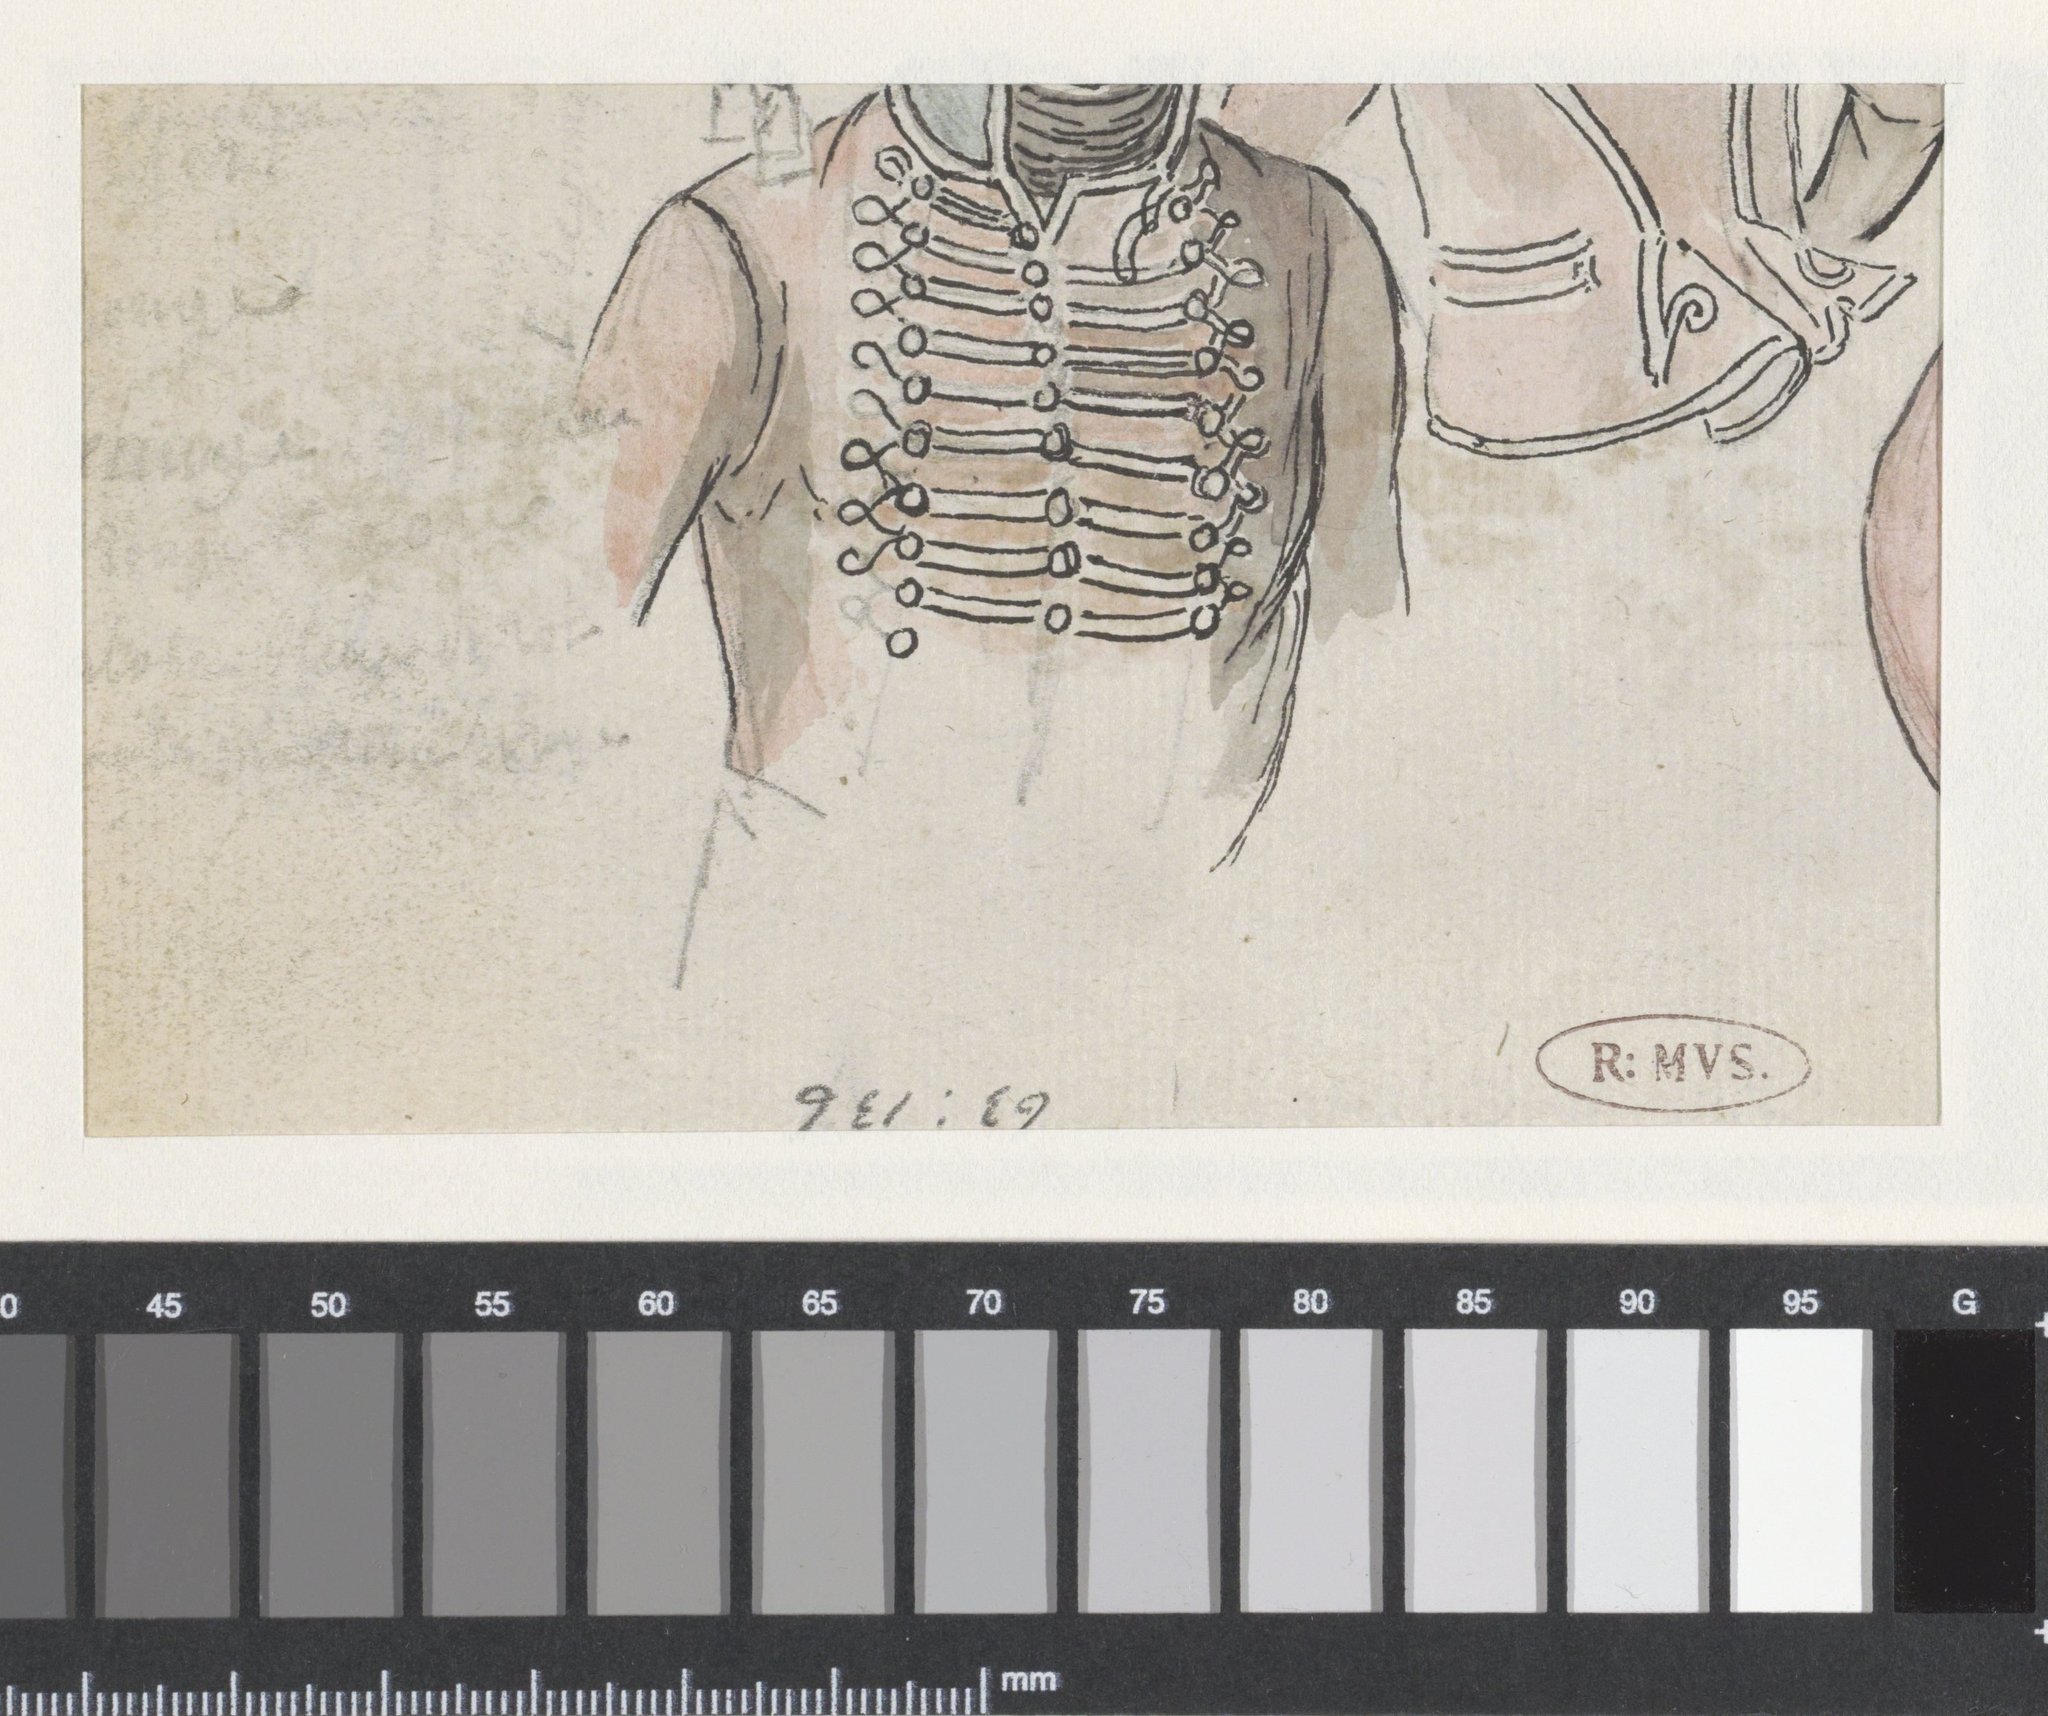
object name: drawing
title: Schetsen van huzaren (afgesneden)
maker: georges michel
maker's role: draughtsman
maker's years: 1763-1843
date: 1773-1843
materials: ink, paper, pencil, watercolor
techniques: brush, pen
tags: (military) uniforms (+ cavalry, horsemen)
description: Een van 120 tekeningen, afkomstig uit een 19e eeuws album met tekeningen van Georges Michel.